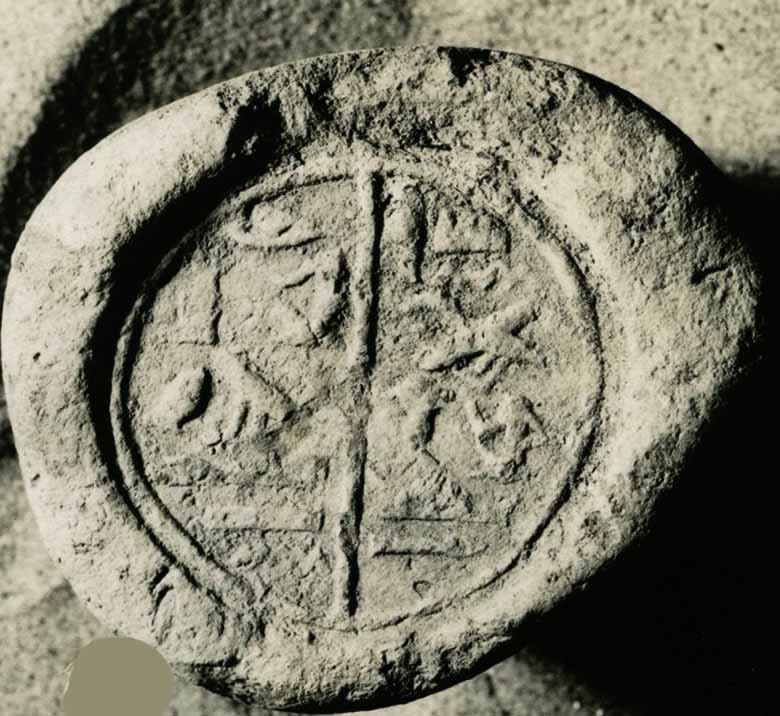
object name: cone, pawah, servant of amun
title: Funerary Cone of the Servant of Amun Pawah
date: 1550-1295 BCE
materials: pottery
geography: egypt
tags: hieroglyphs